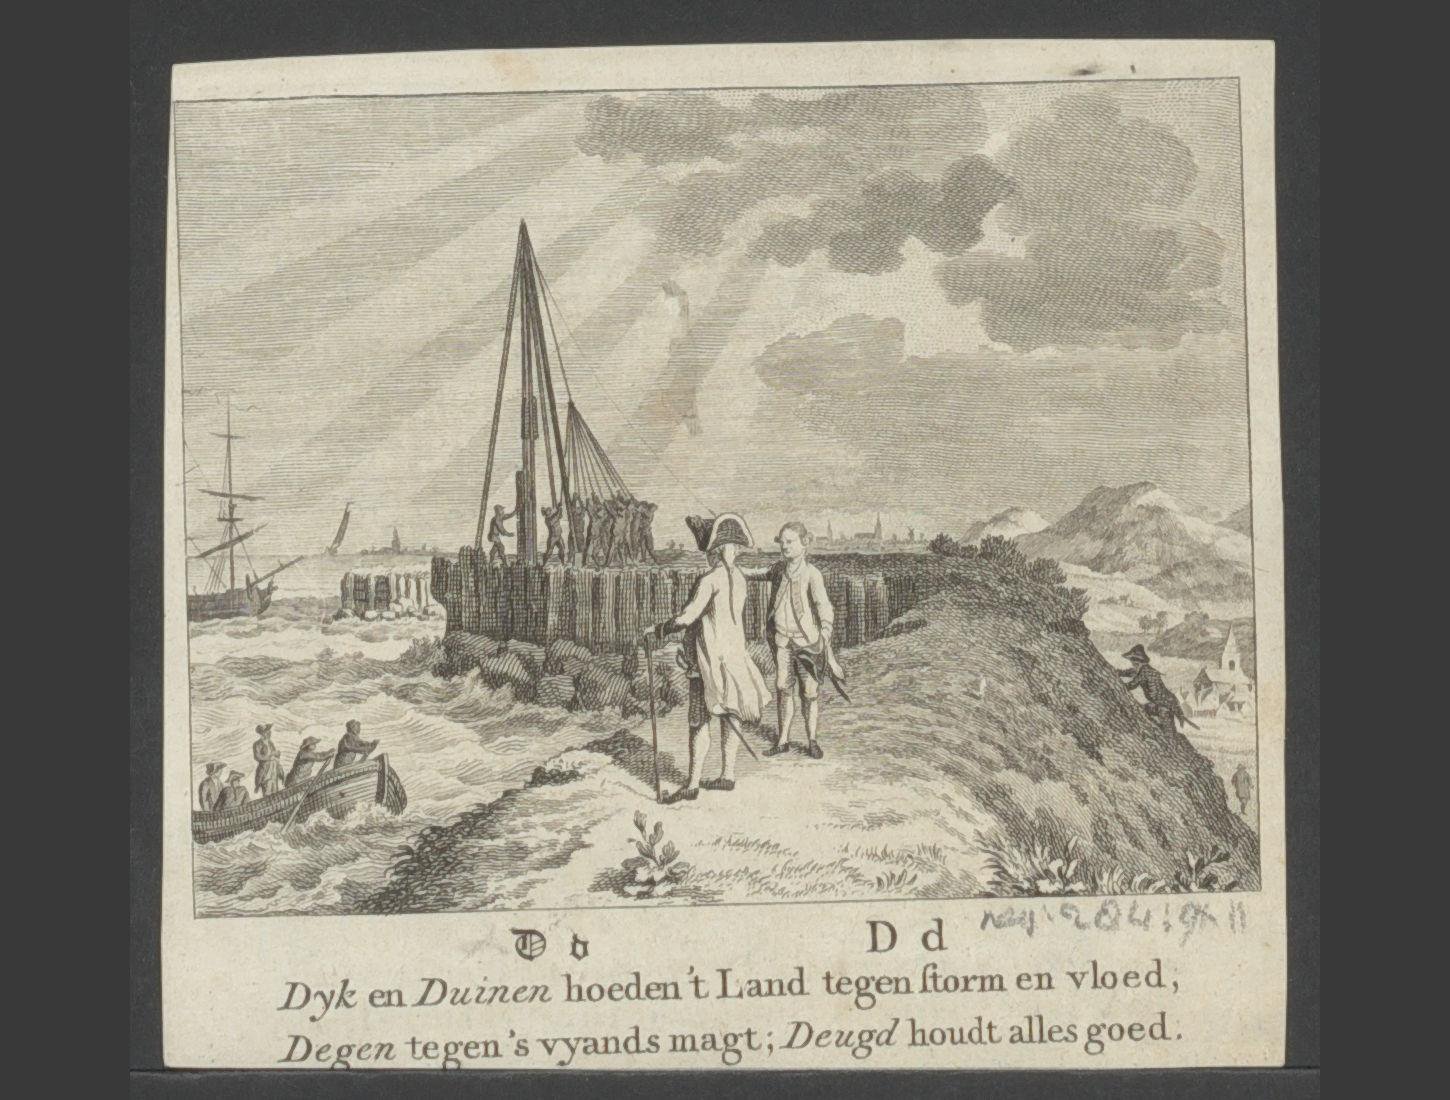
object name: print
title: Dyk en Duinen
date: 1781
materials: paper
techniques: engraving, etching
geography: amsterdam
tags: dune coast, letters, alphabet, script, dikes, levee, dikes, levee (+ landscape with figures, staffage)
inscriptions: stamp, collector's mark: Lugt 1641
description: Twee mannen kijken naar de aanleg van een dijk. Onder de voorstelling de letter D in twee verschillende lettertypes. Onderaan een tweeregelig vers over dijken en duinen. Onderwerpsrubrieken binnen de Atlas Zeden en Gewoonten: Onderwijs en Wetenschappen, Opvoeding en Onderwijs, Haneboeken en schoolprenten.